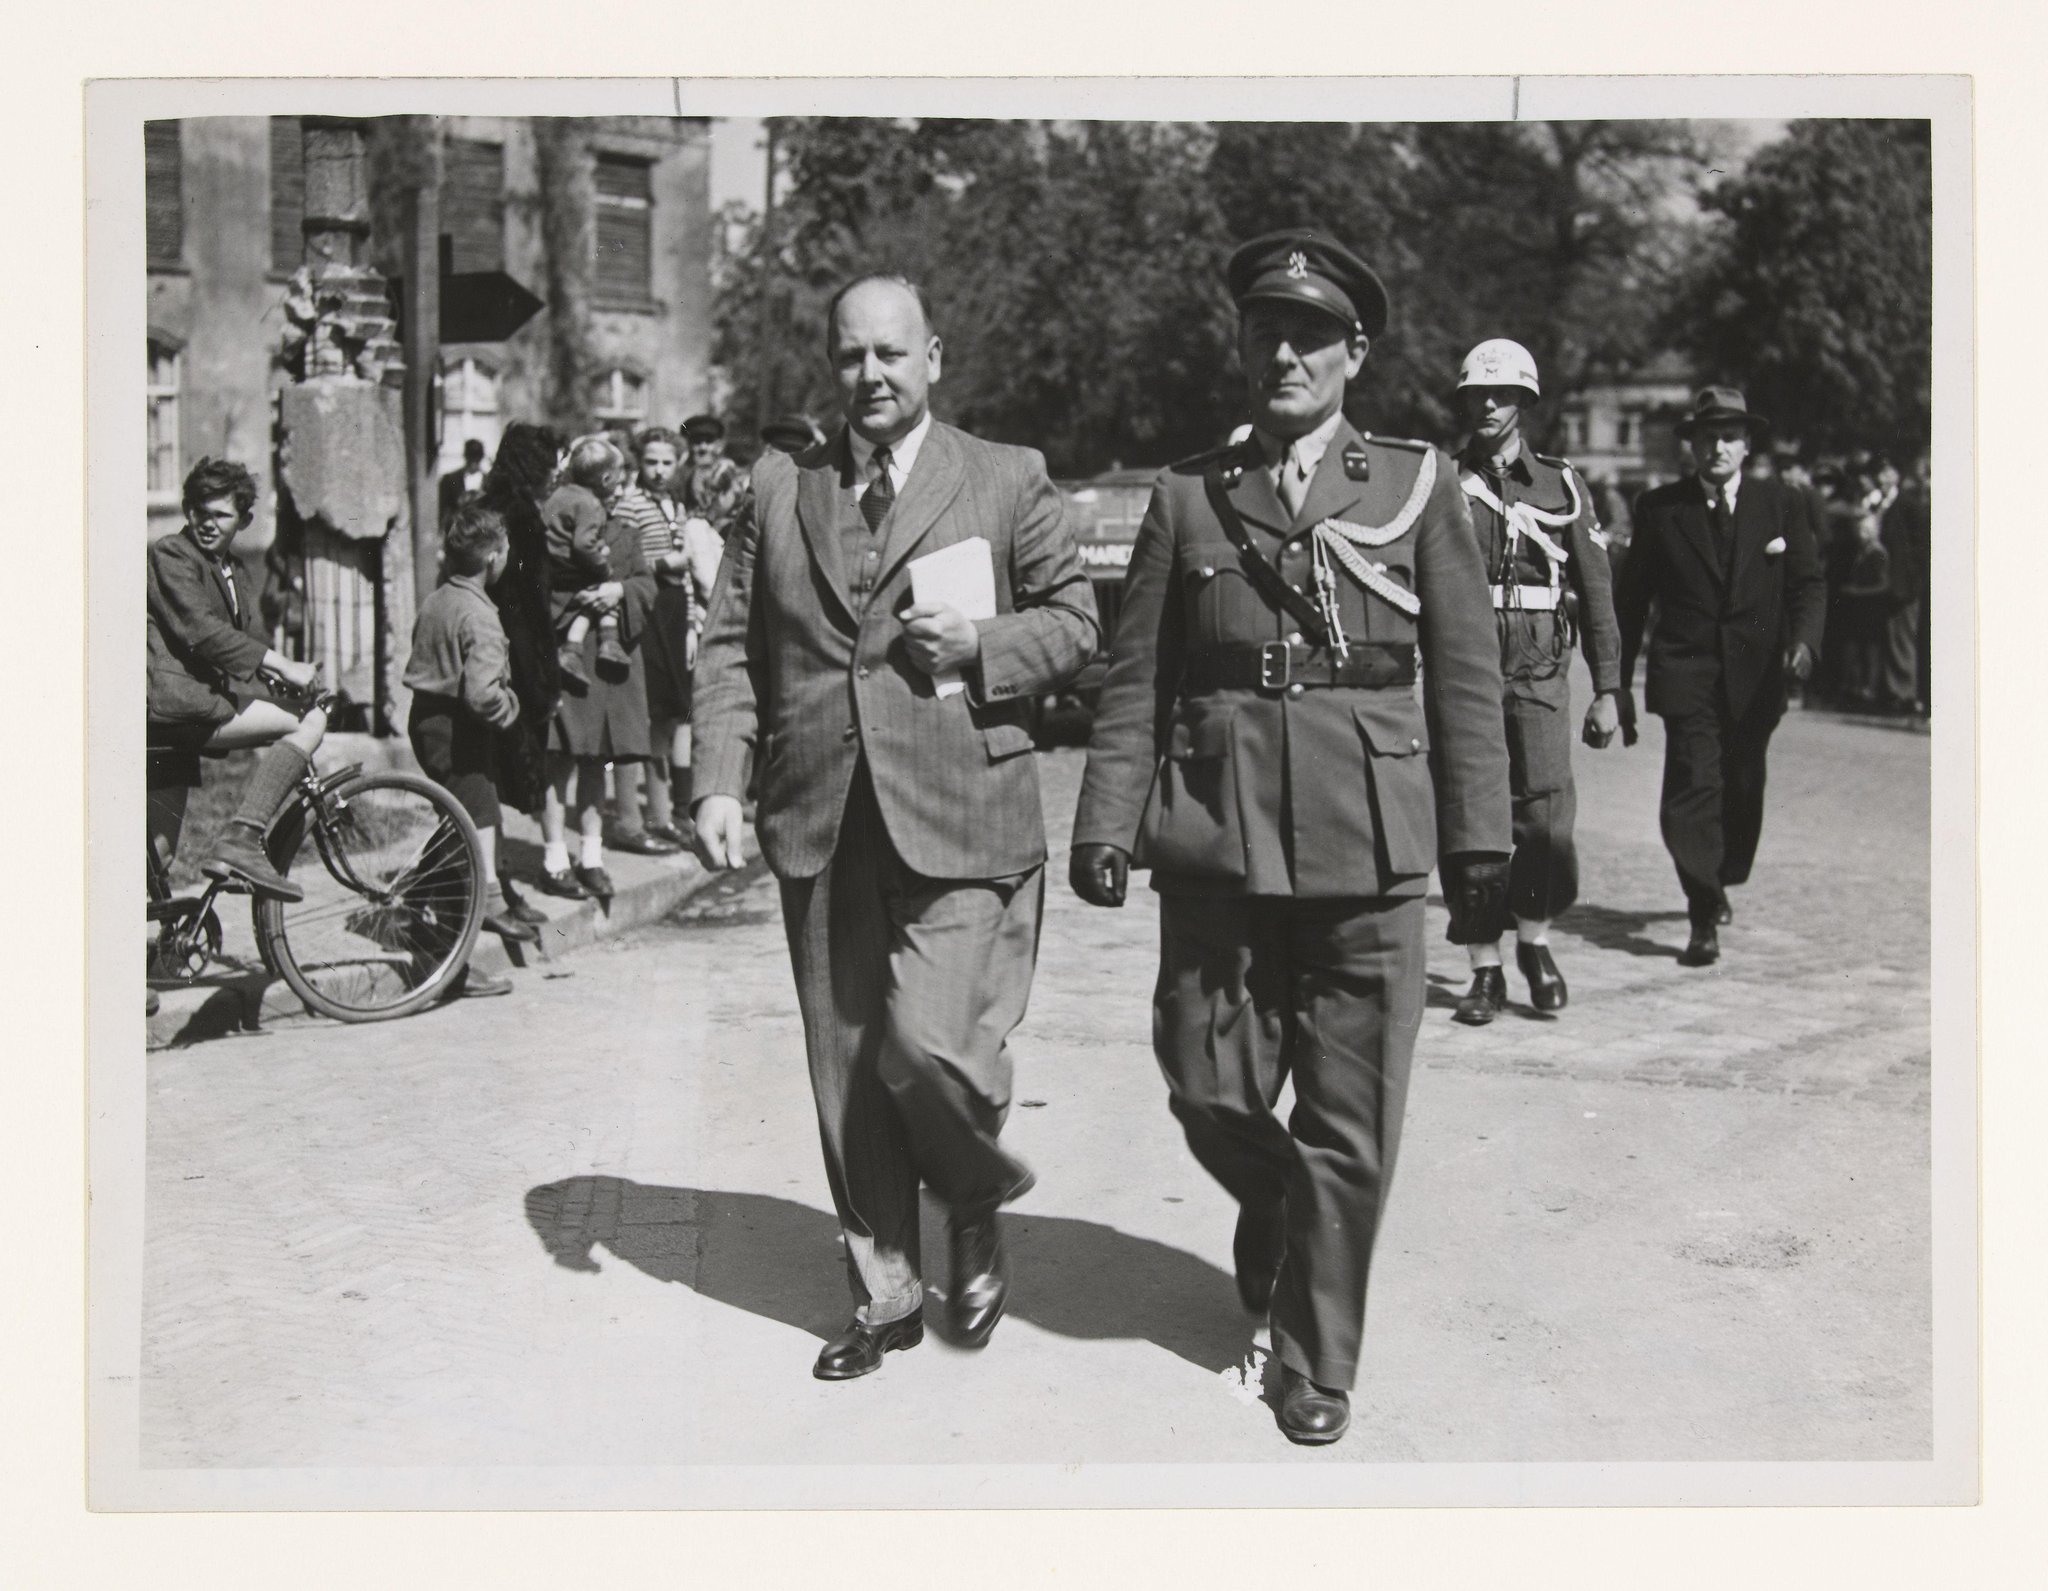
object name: documentary photograph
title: Bestuursoverdracht Elten: landdrost Blaauboer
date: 1949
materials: photographic support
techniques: photography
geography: elten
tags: blaauboer, a., elten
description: De landdrost A. Blaauboer en luitenant-kolonel De Zeeuw wandelen Elten binnen op weg naar het stadhuis waar de burgemeester baron Lochner von Hüttenbach zijn bevoegdheden overdroeg.